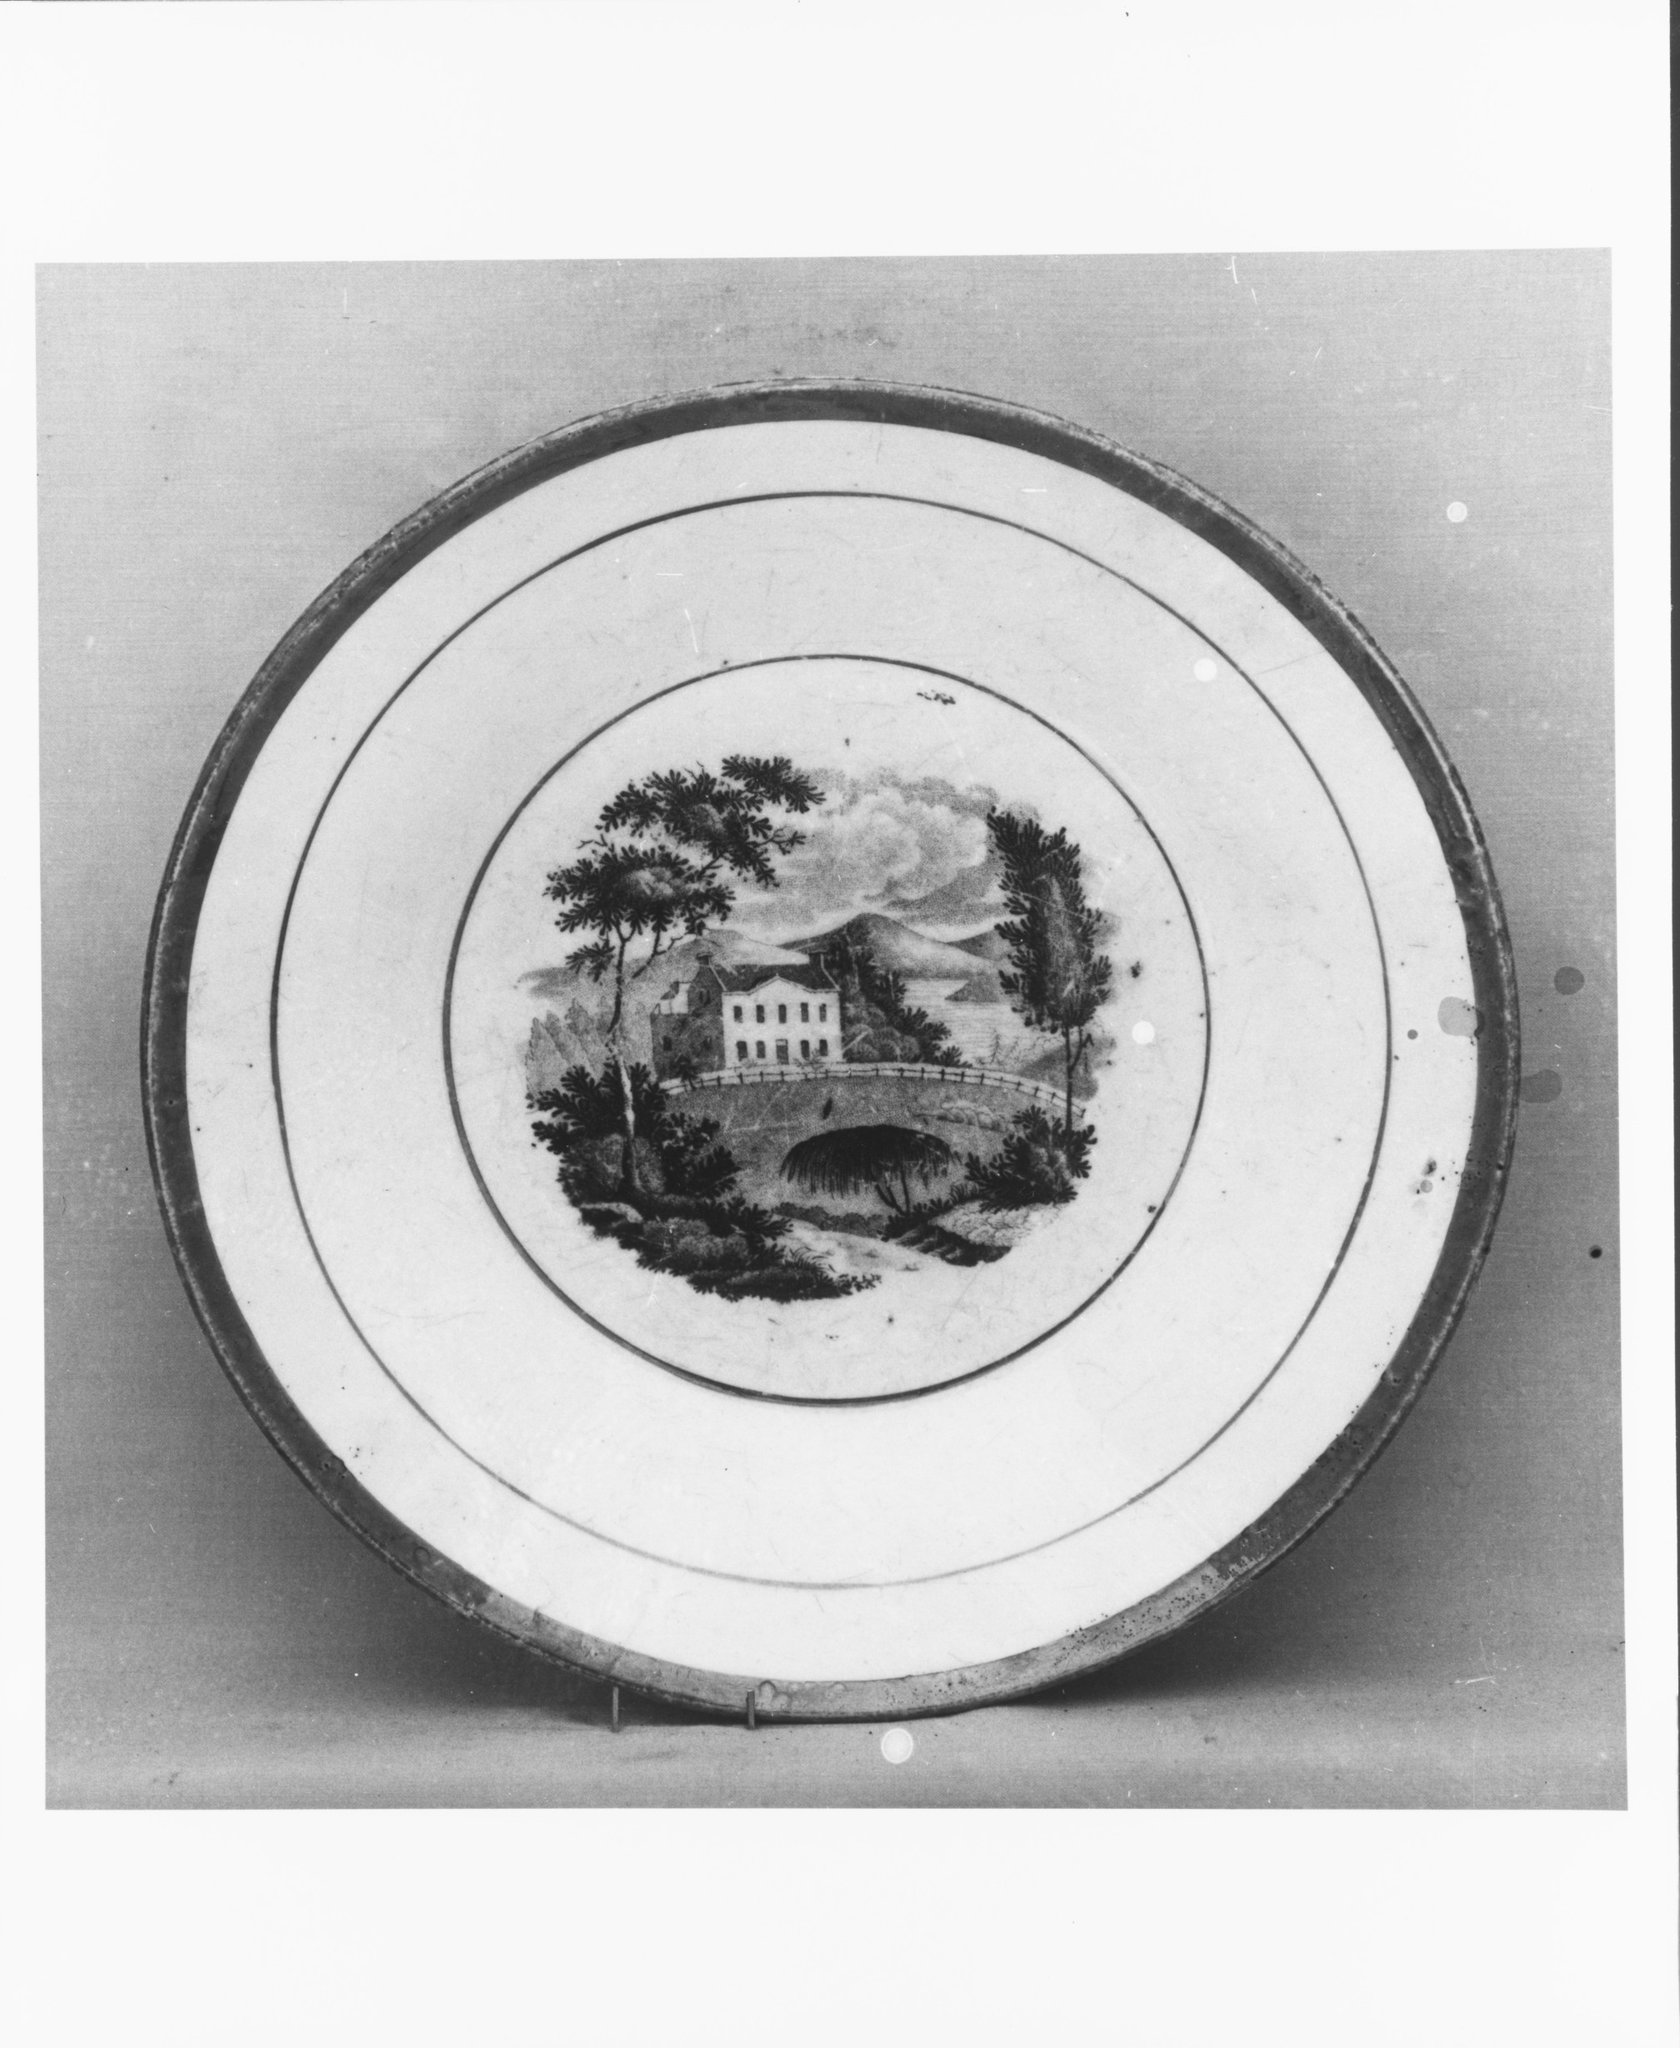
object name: plate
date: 1767-1800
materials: earthenware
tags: houses,mountains,trees